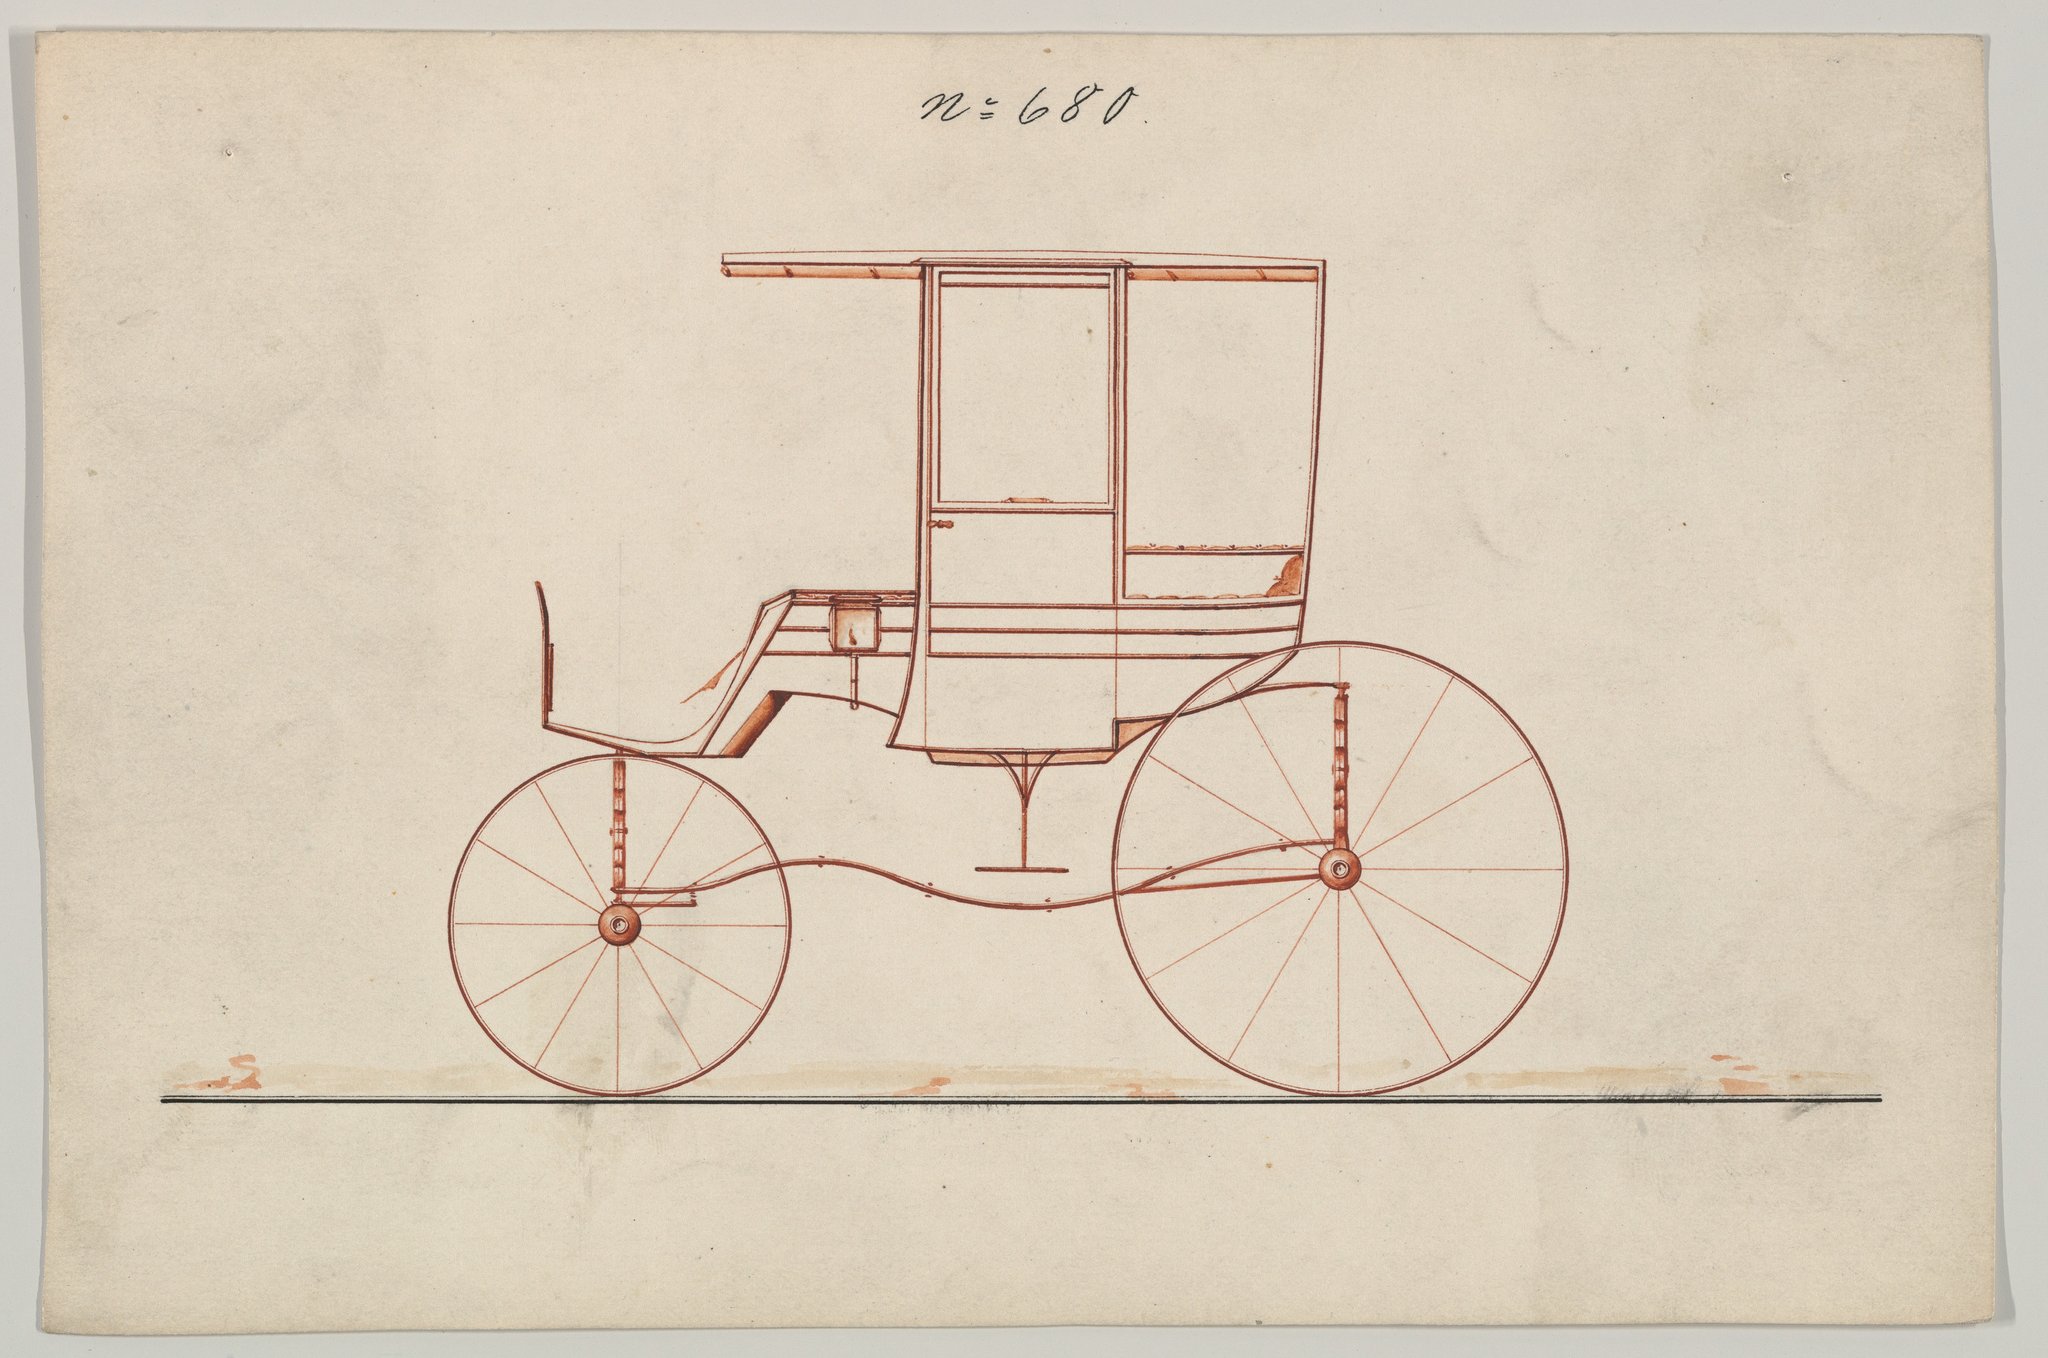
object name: drawing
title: Rockaway #680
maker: brewster & co.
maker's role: manufacturer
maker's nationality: american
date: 1865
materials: watercolor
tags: carriages